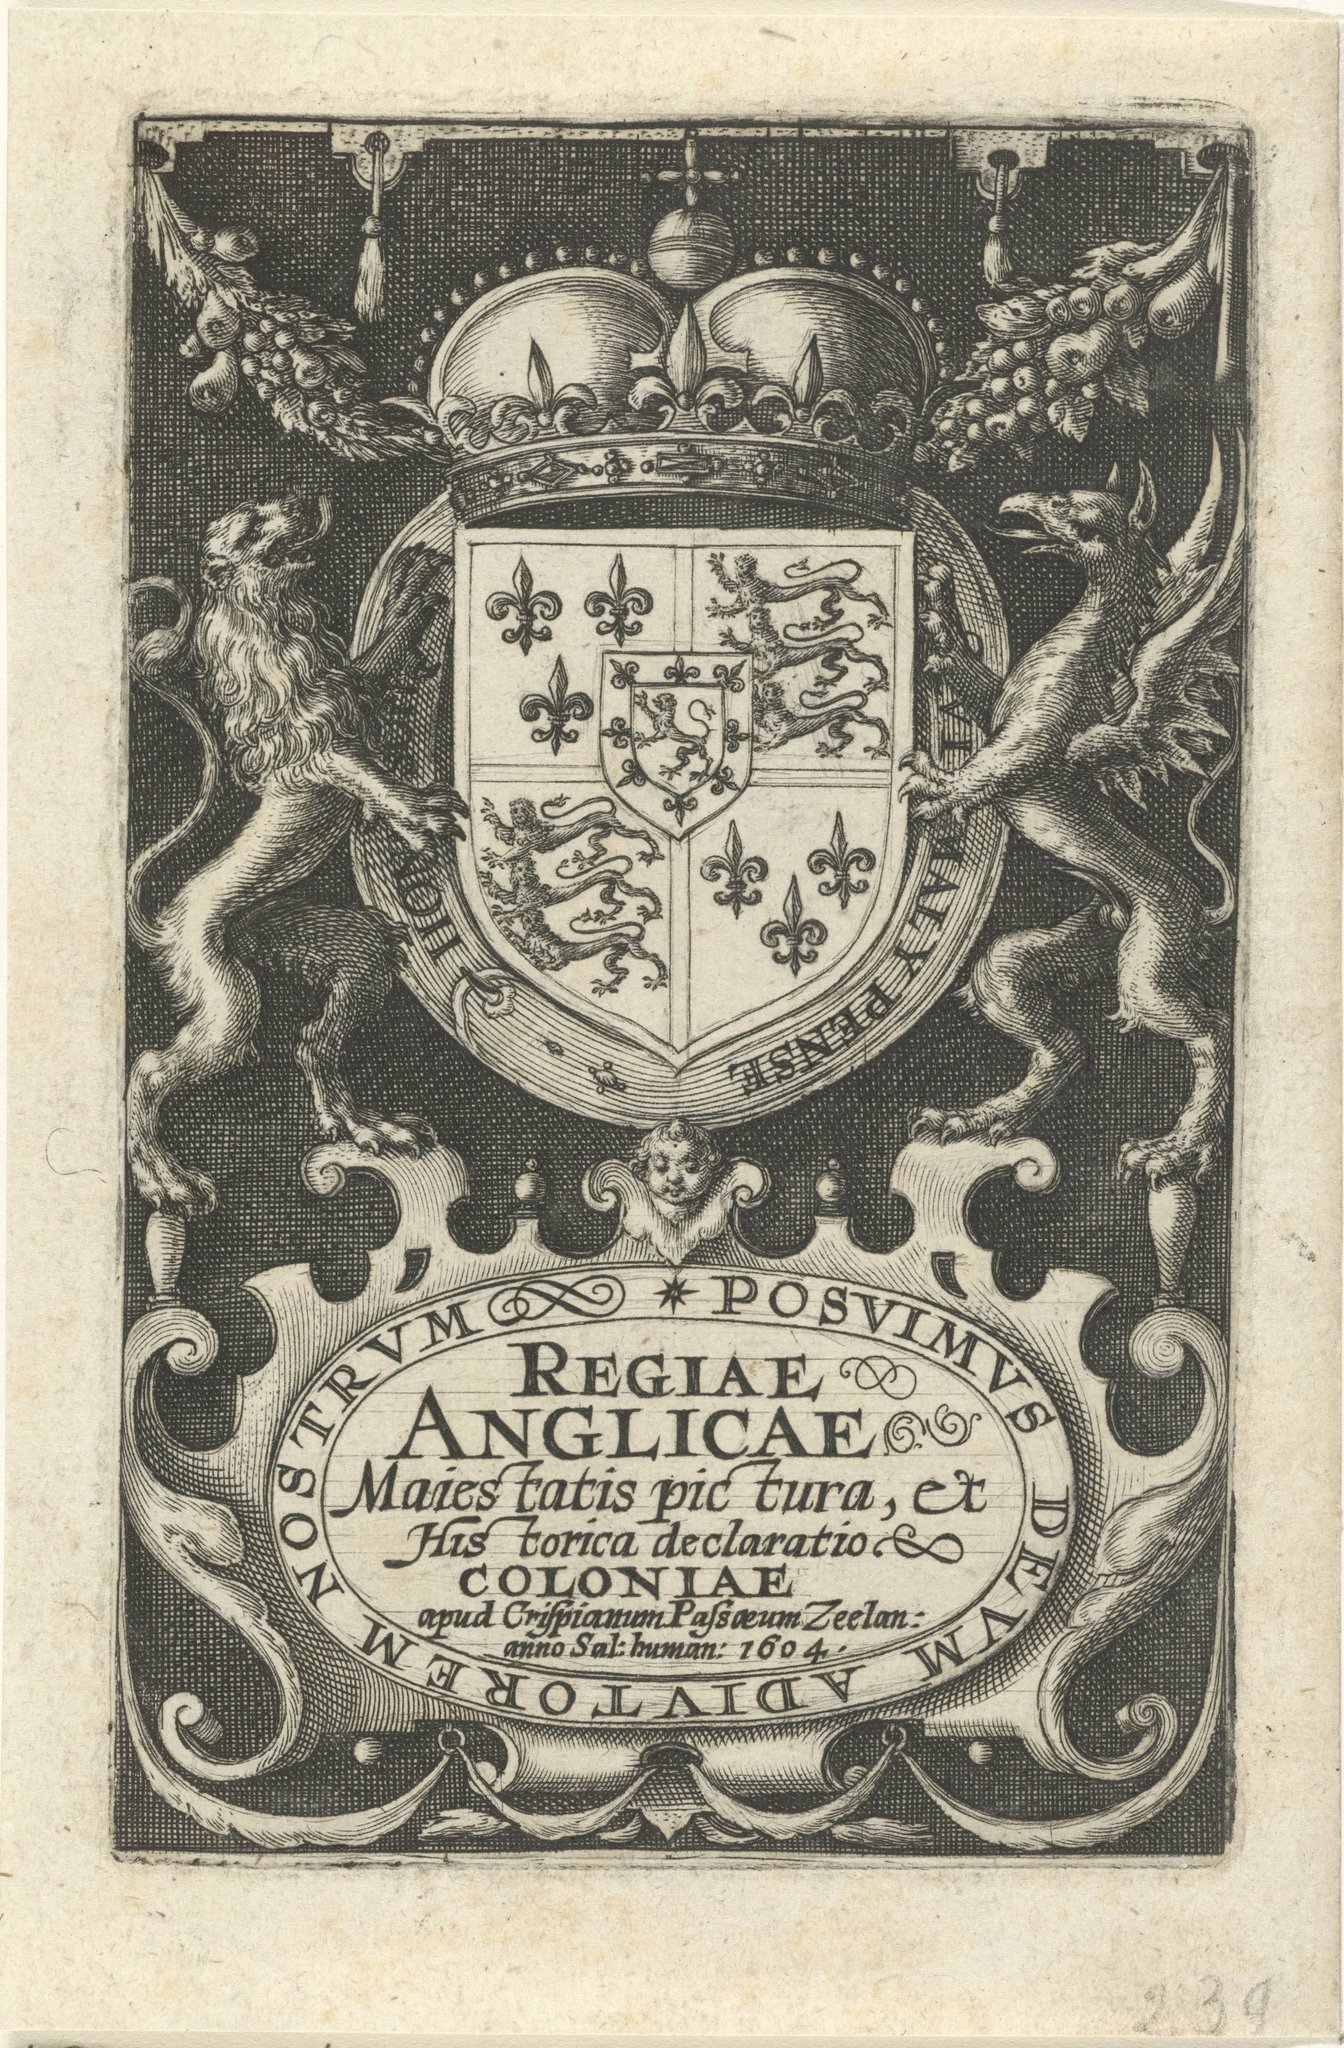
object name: titelprent, frontispice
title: Regiae Anglicae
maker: crispijn van de passe (i)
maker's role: draughtsman, print maker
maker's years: 1564-1637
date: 1604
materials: paper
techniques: engraving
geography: cologne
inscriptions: collector's mark: Lugt 2228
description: Wapenschild van Engeland, eronder een ovale omlijsting met de serietitel in het Latijn. Titelprent voor een serie met portretten van Engelse vorsten.